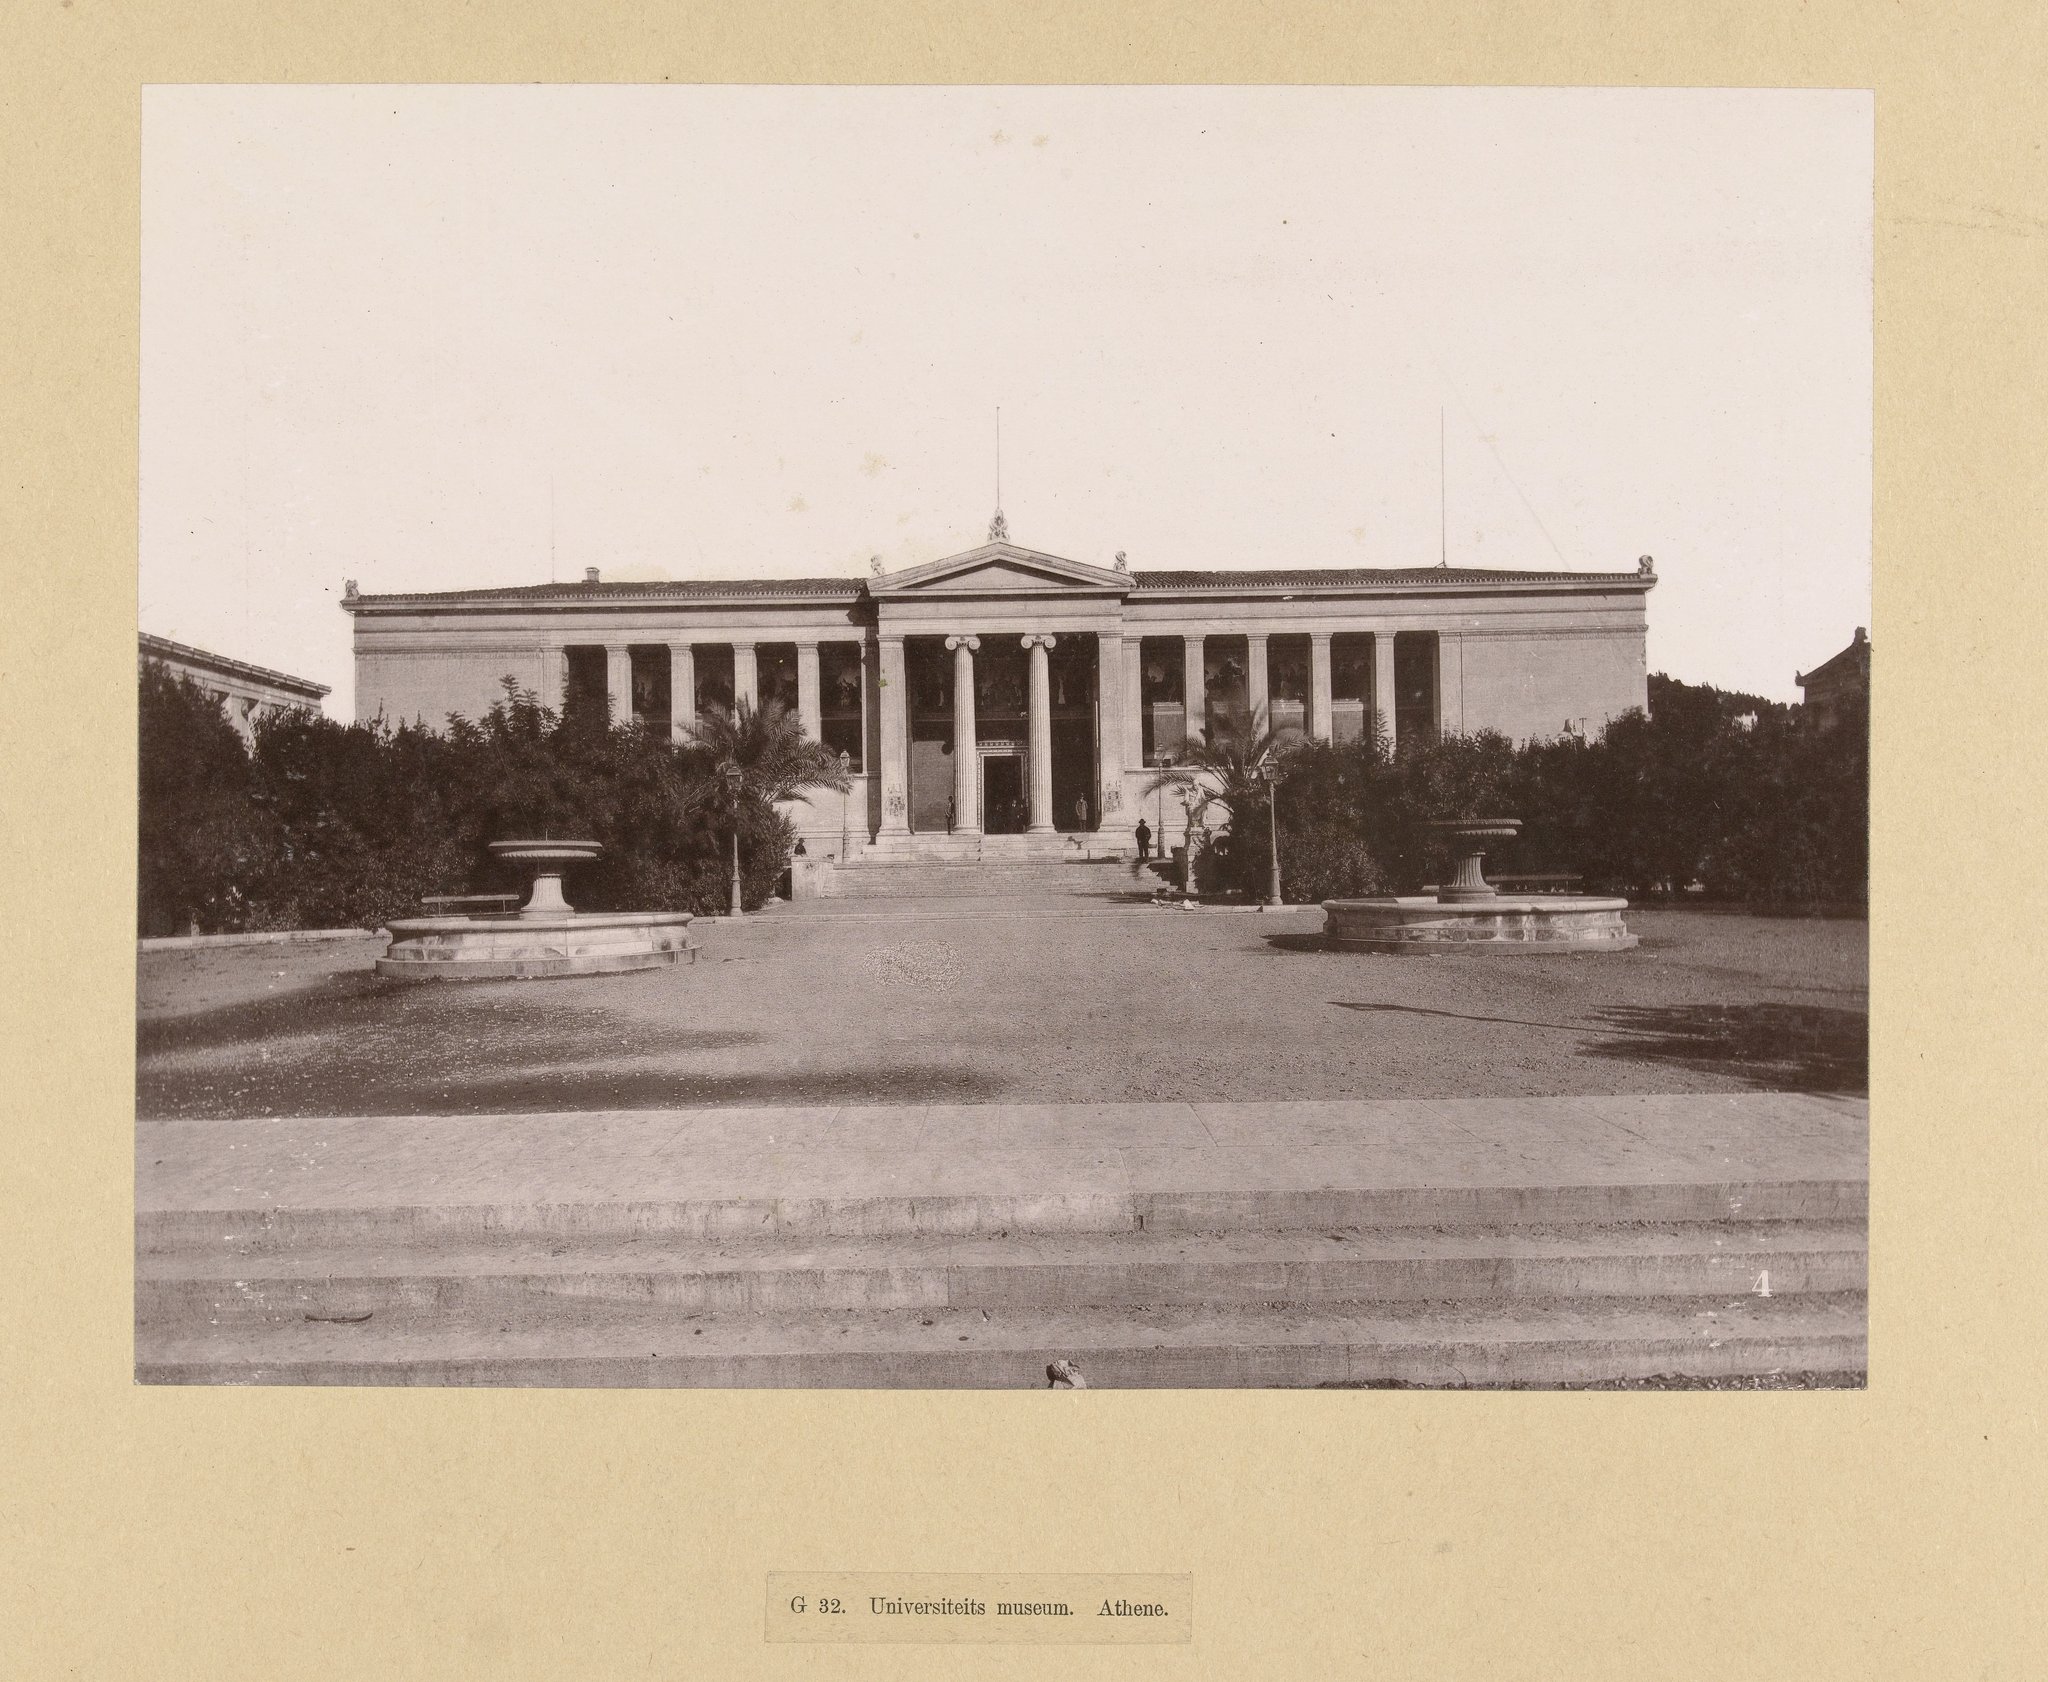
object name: photomechanical print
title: G 32. Universiteits museum. Athene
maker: Anonymous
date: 1890-1895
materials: cardboard, paper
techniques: photograph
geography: athens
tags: university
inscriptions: check stamp: ‘Bristol/ L.M.’, stamp: ‘Gemeentelijke bibliotheek/ Rotterdam’, number: ‘4’, title: ‘G 32. Universiteits museum. Athene.’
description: Onderdeel van een groep door fotograaf Richard Polak op reis verzamelde foto’s. Deze fotomechanische afdruk is samen met andere op zijn reizen verzamelde foto's tentoongesteld bij de Rotterdamsche Kunstkring (1895), Arti en Amicitiae te Amsterdam (1897-1898?) en Societeit 't Collegie te Kampen (datum vooralsnog onbekend).